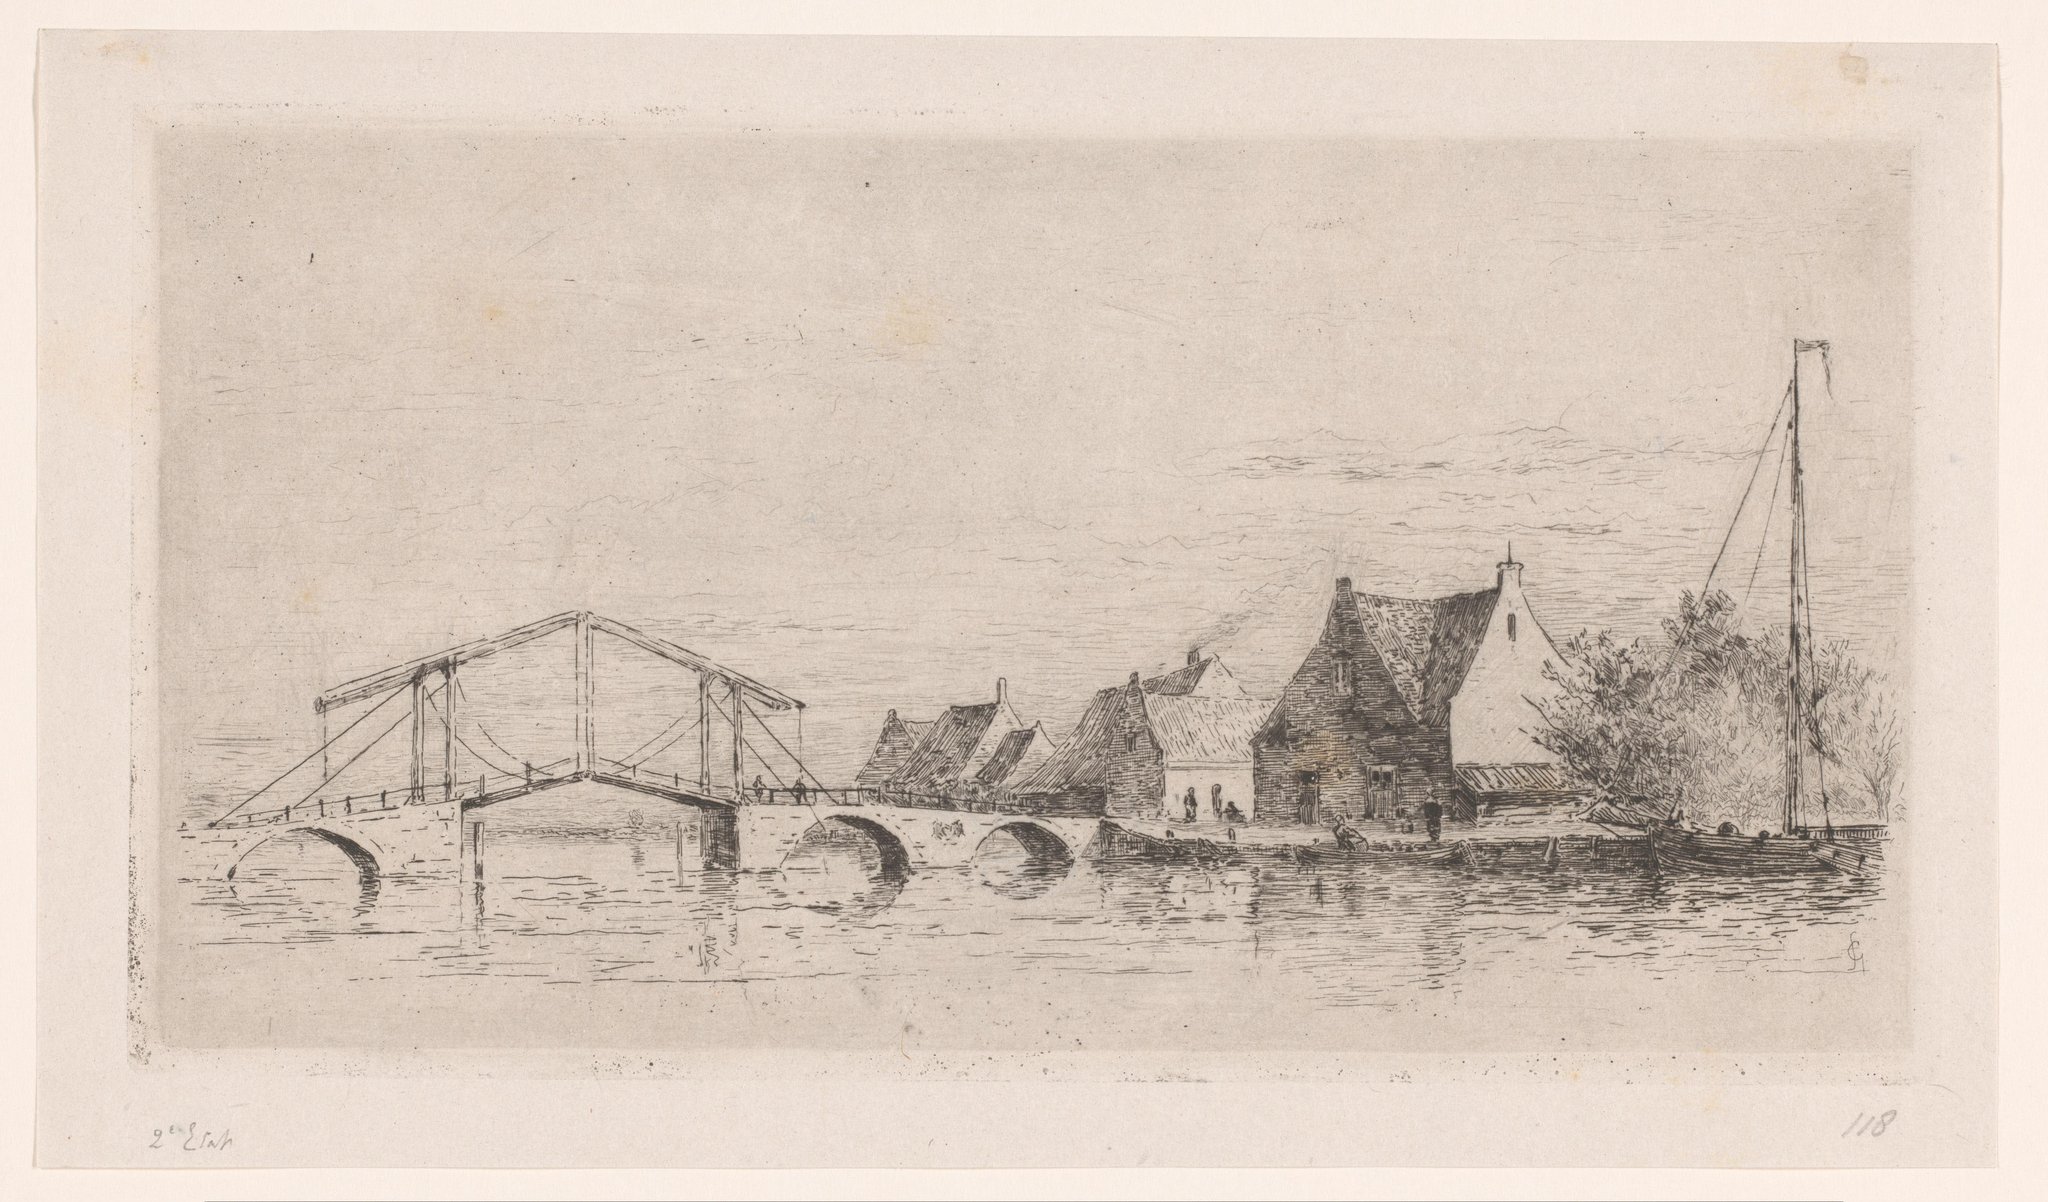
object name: print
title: Pont à Overschie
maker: carel nicolaas storm van s-gravesande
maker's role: draughtsman, print maker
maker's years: 1841-1924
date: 1880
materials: paper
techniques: etching, intaglio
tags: bridge in city across river, canal, etc. (+ city(-scape) with figures, staffage), overschie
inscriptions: collector's mark: Lugt 2228